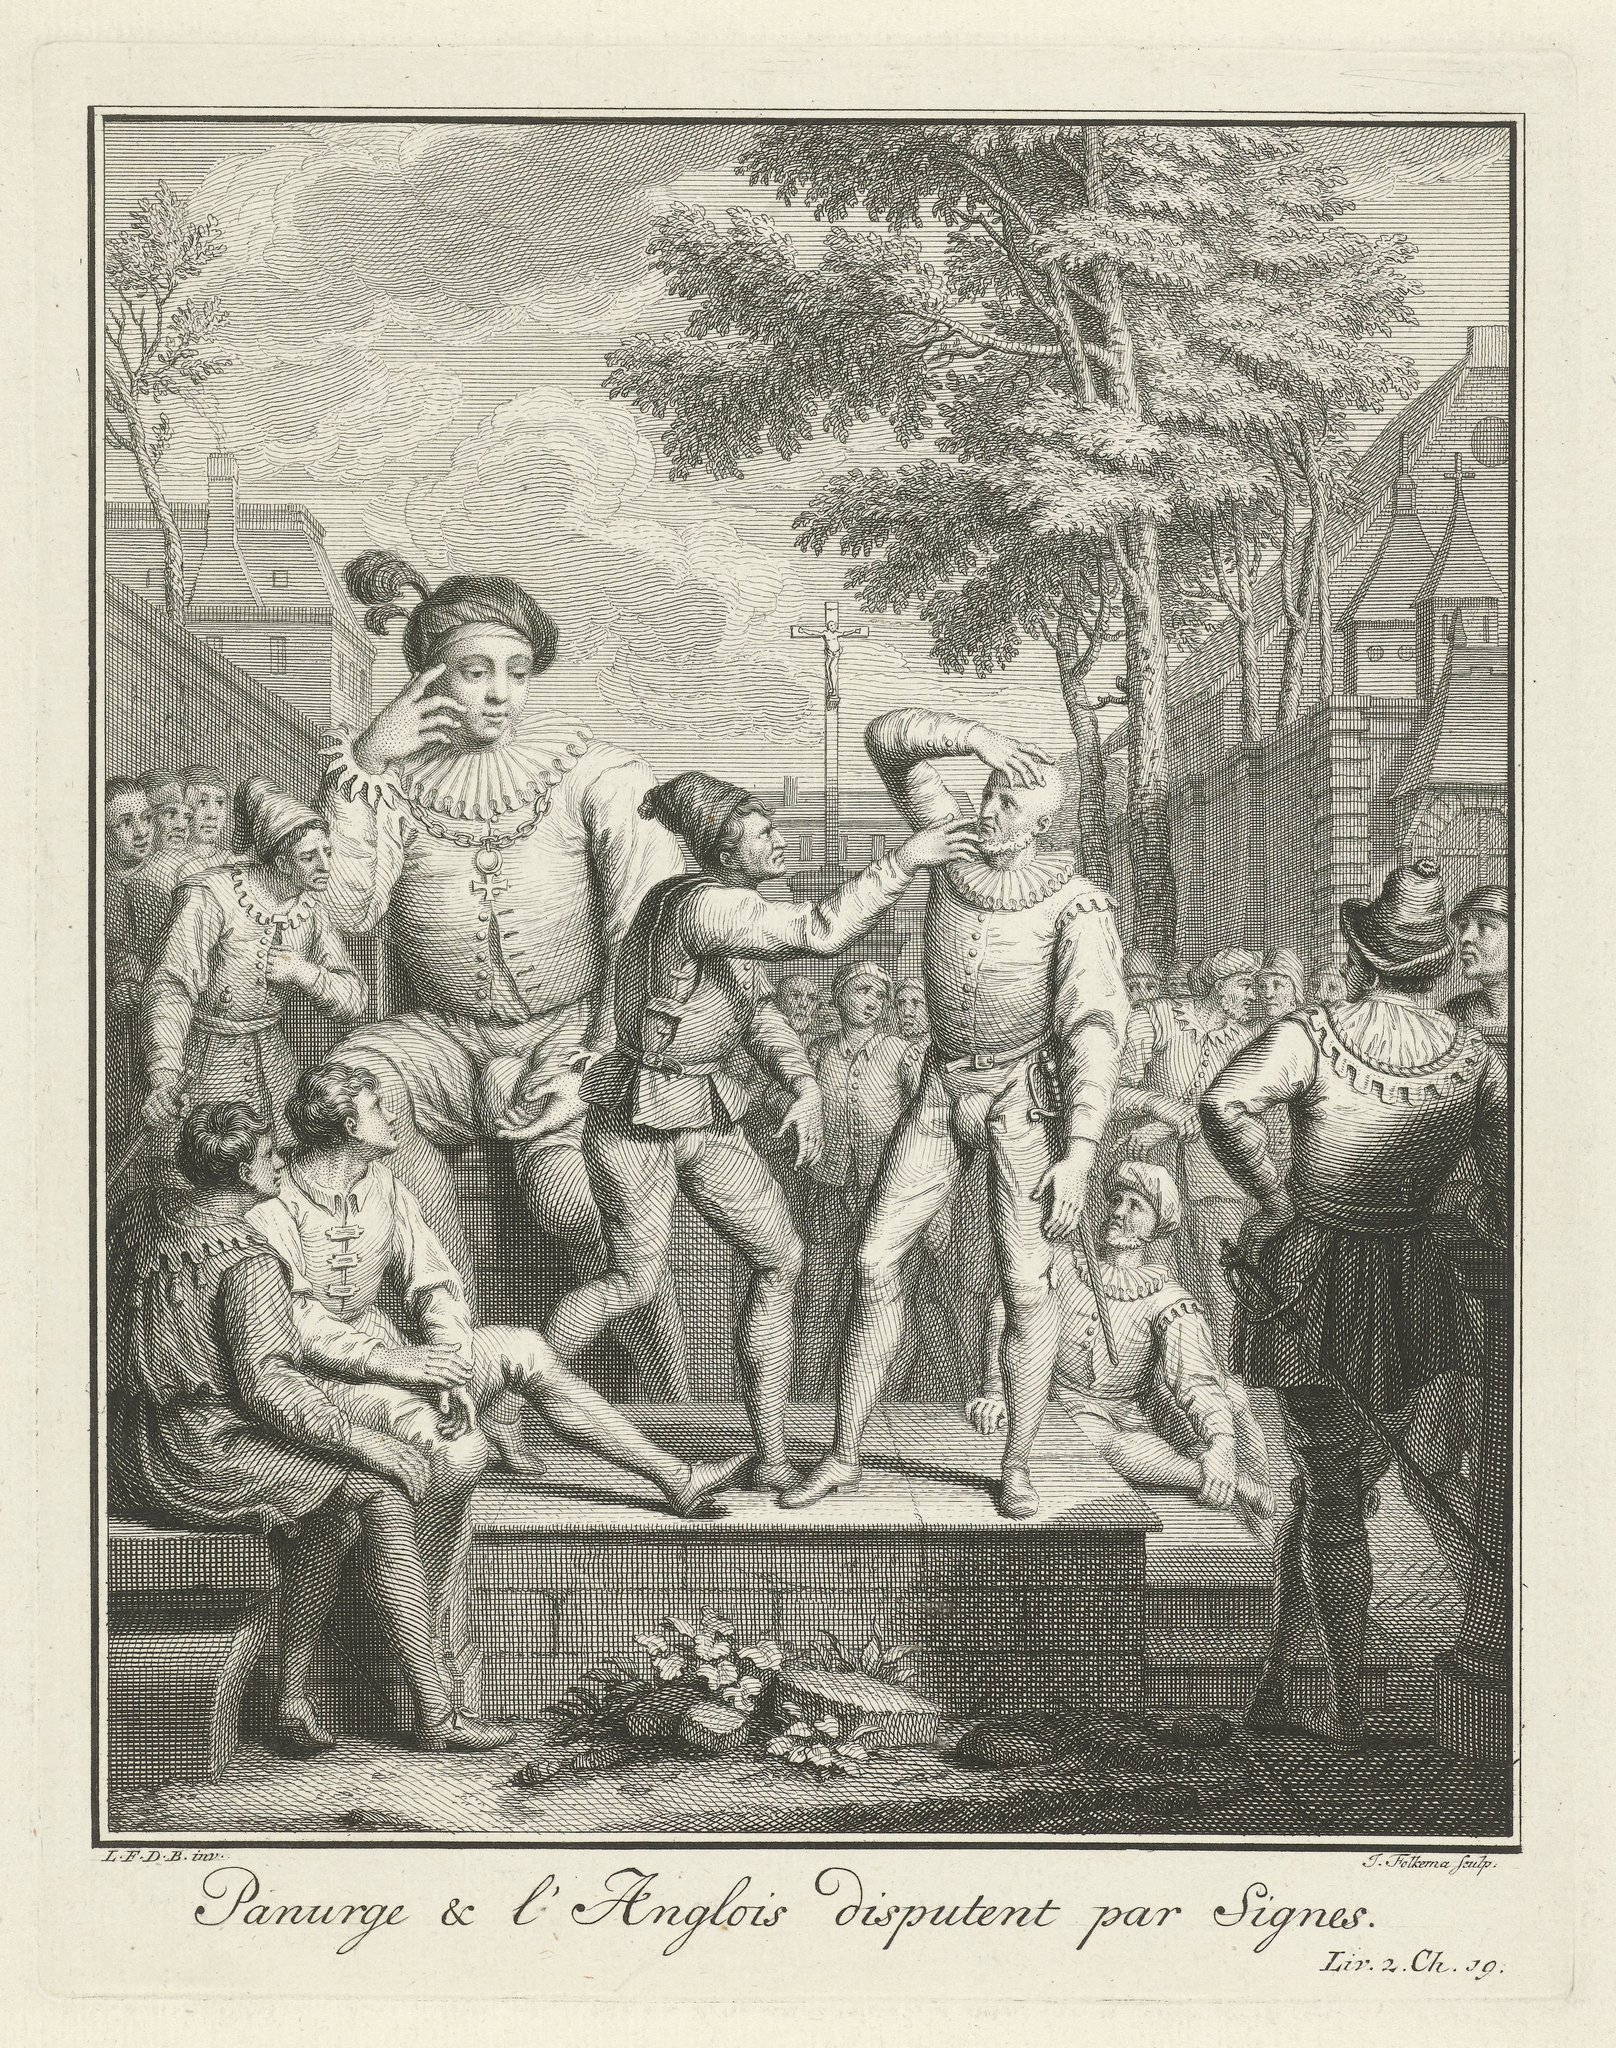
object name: book illustration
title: Avonturen van Gargantua and Pantagruel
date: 1703-1767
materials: paper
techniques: etching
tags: giants, colossi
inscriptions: collector's mark: Lugt 240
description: Panurge inspecteert het gezicht van een Engelsman en steekt daarbij zijn vinger in zijn neus. De reus Gargantua zit achter dit tweetal op een muurtje en kijkt samen met een groep nieuwsgierige mensen toe. In de marge staat een regel tekst in het Frans, rechtsonder gemerkt: Liv. 2. Ch. 19.